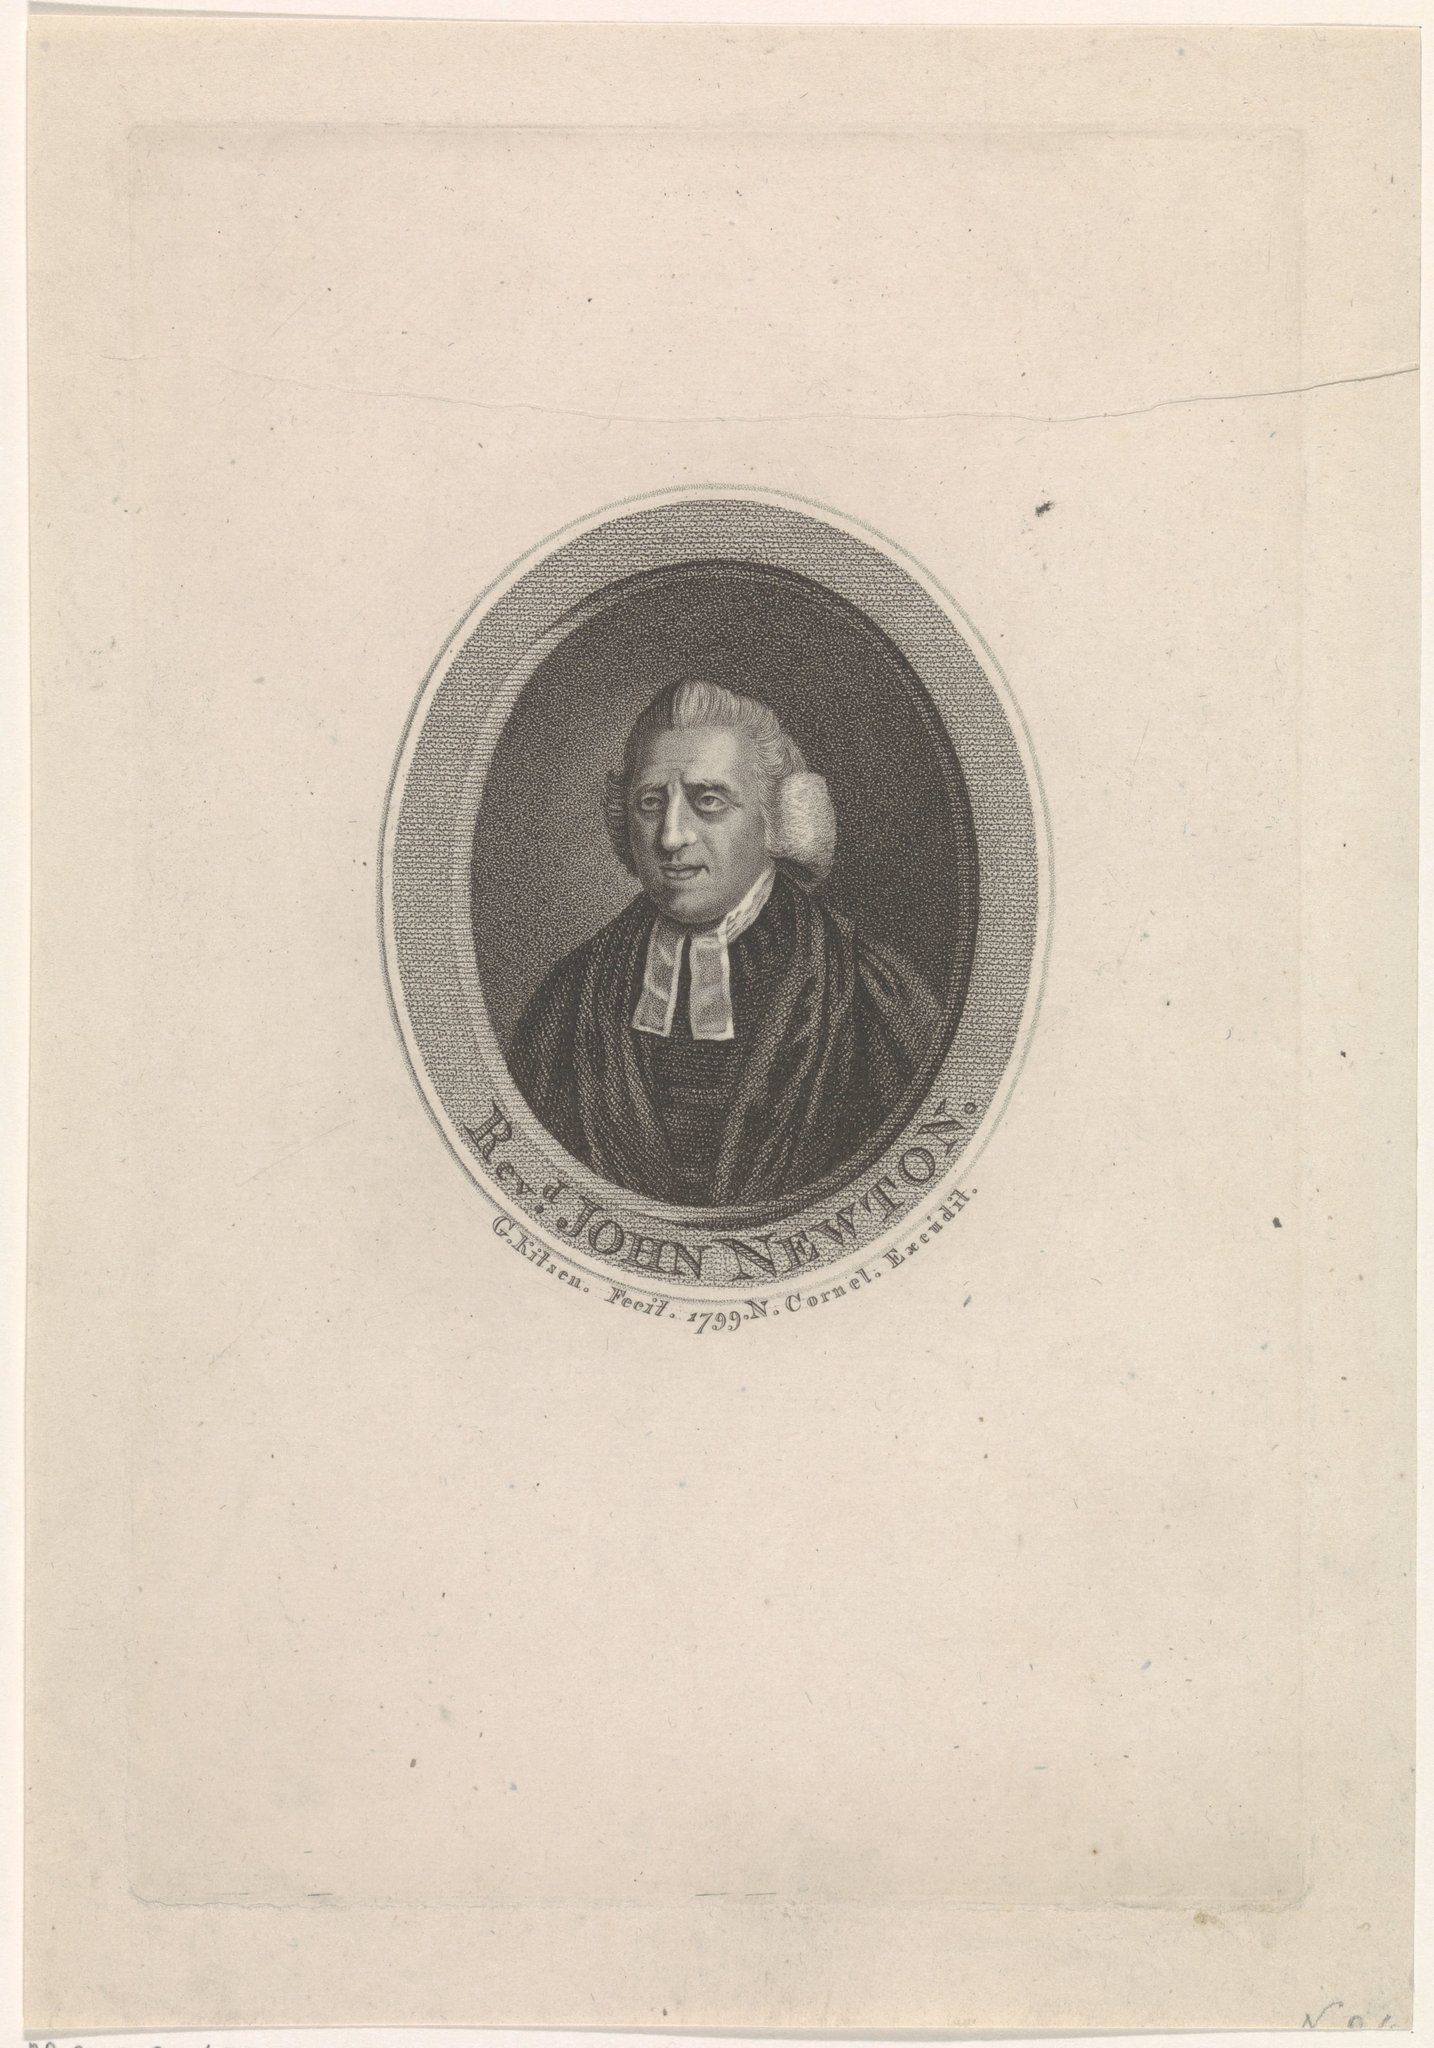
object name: print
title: Portret van John Newton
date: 1799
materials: paper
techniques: aquatint, etching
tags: historical persons, slavery; serfs and enslaved persons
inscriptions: collector's mark: Lugt 2228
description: Portret van John Newton, kapitein op slavenschepen, zelf enkele jaren tot slaaf gemaakt in West-Afrika (1745-1748), slavenhandelaar, Anglicaans pastoor en later abolutionist. Hij draagt liturgische kleding en een gespleten bef.